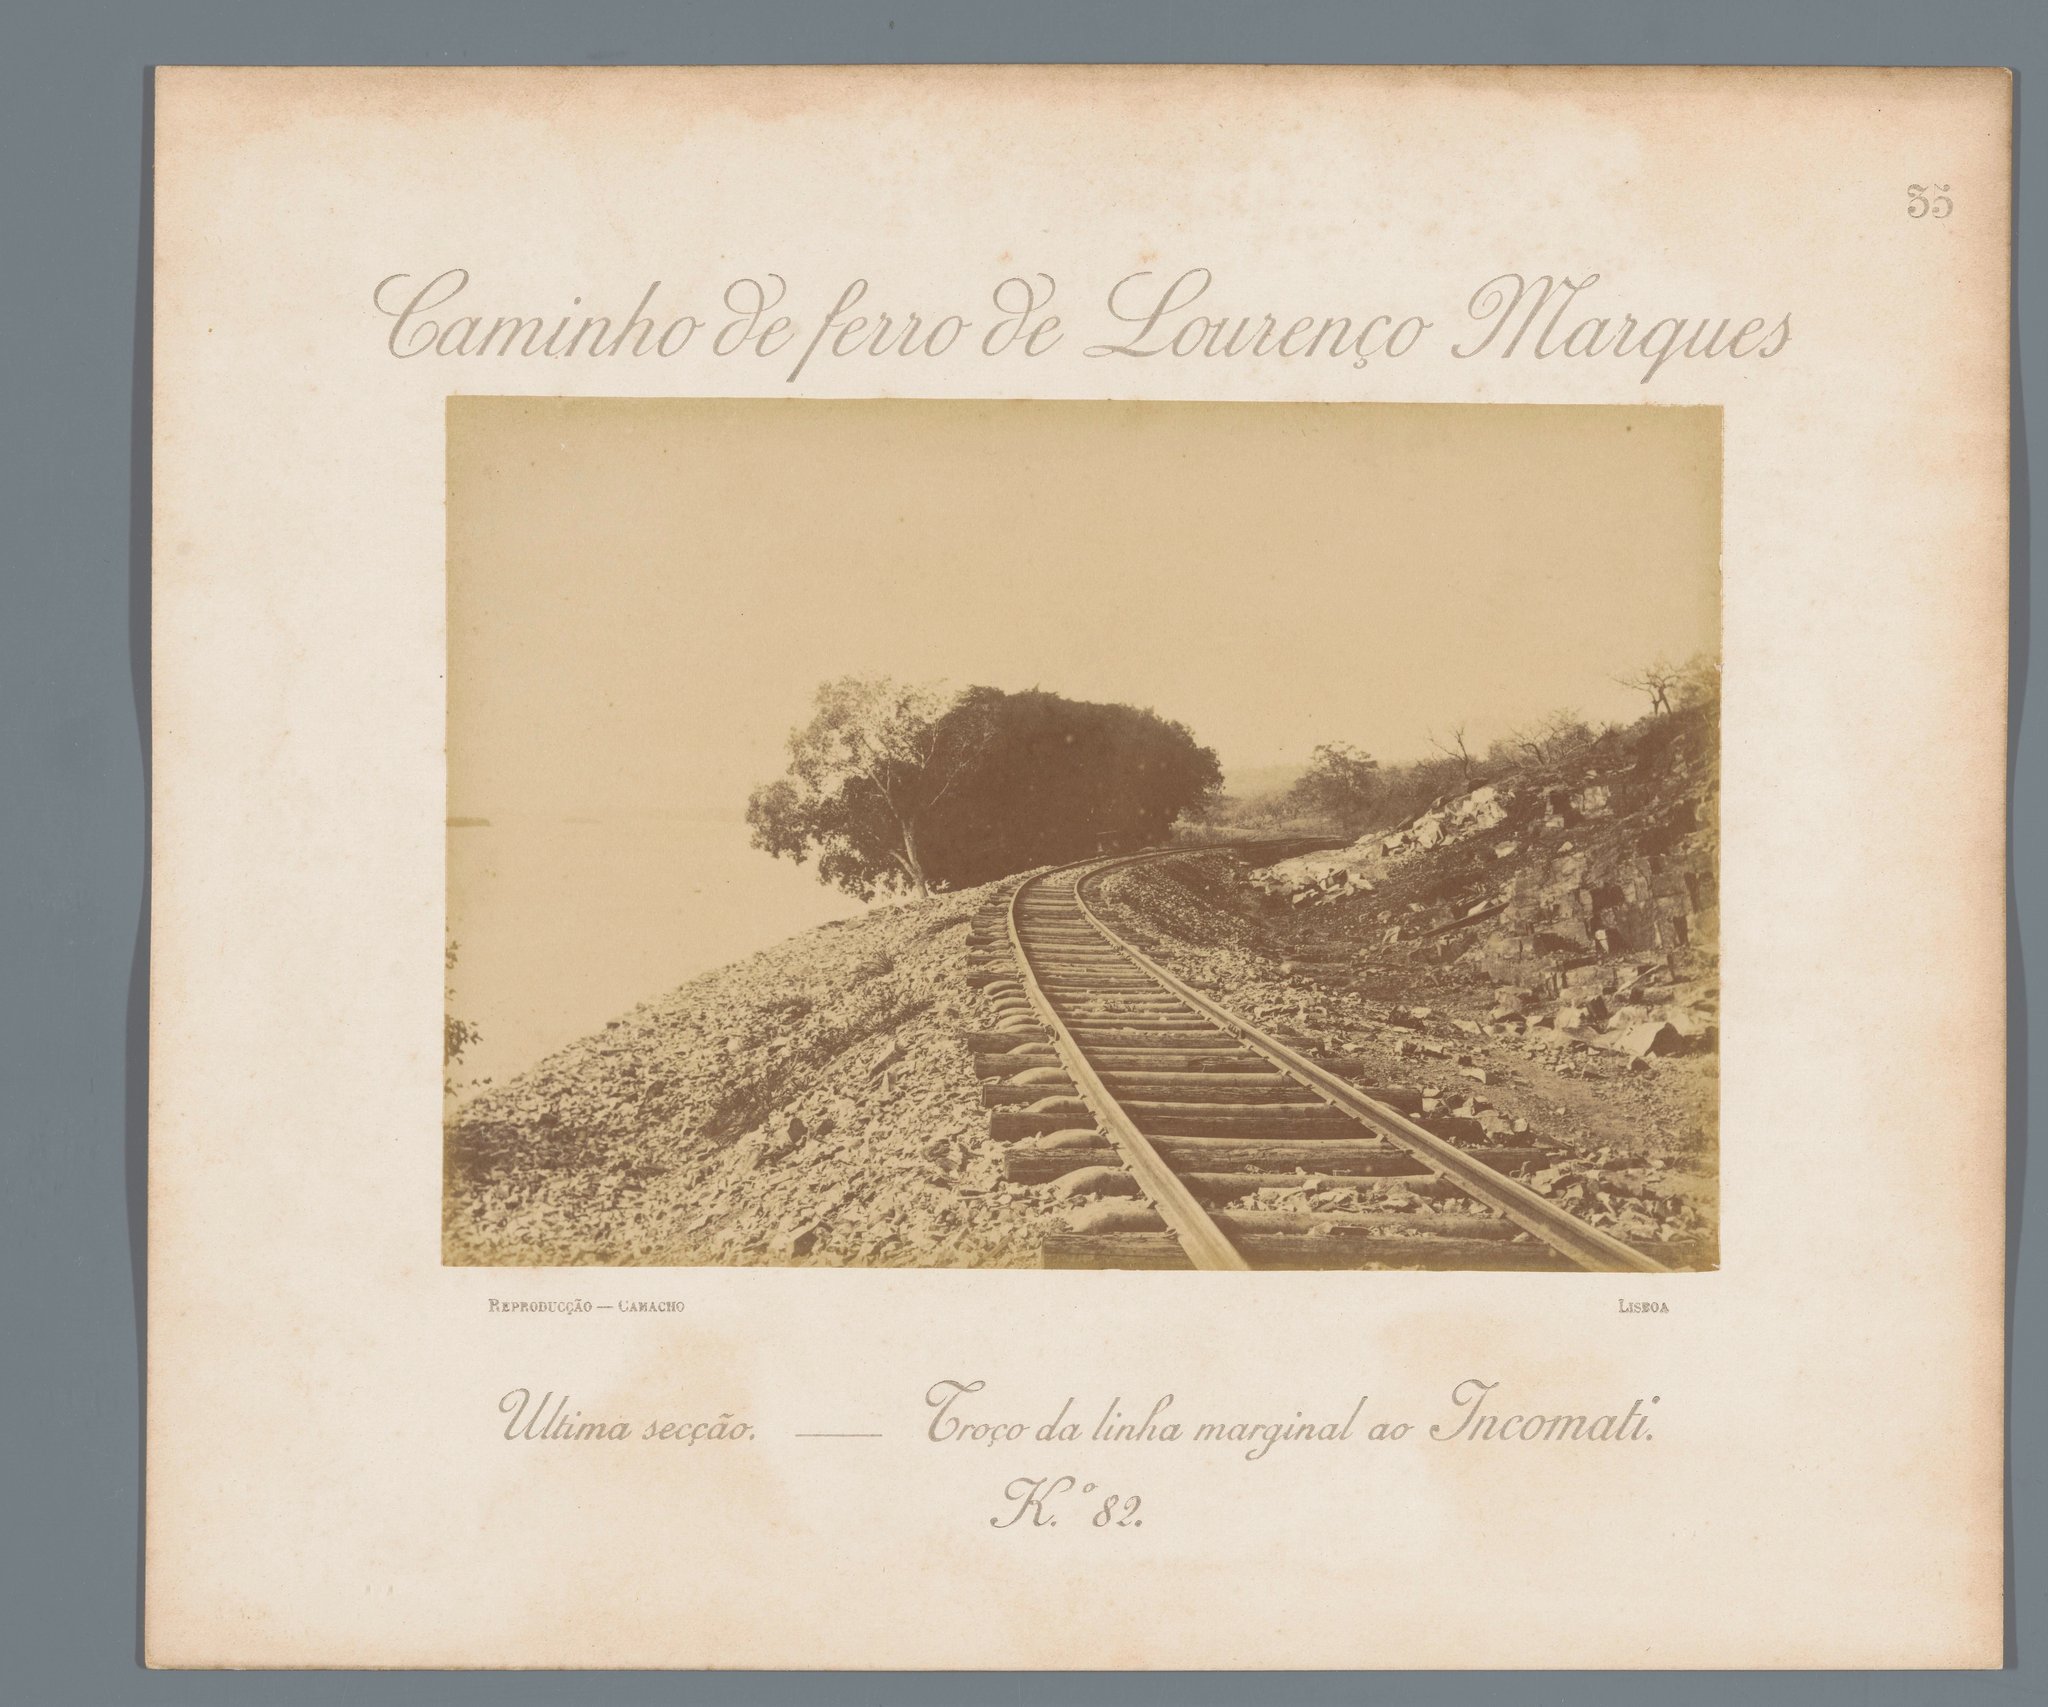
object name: photograph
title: Treinspoor in Mozambique, mogelijk langs de oever van de Rio Incomati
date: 1886-1895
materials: photographic support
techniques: albumen print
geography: lisbon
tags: river, railway, train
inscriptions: number: ‘35’